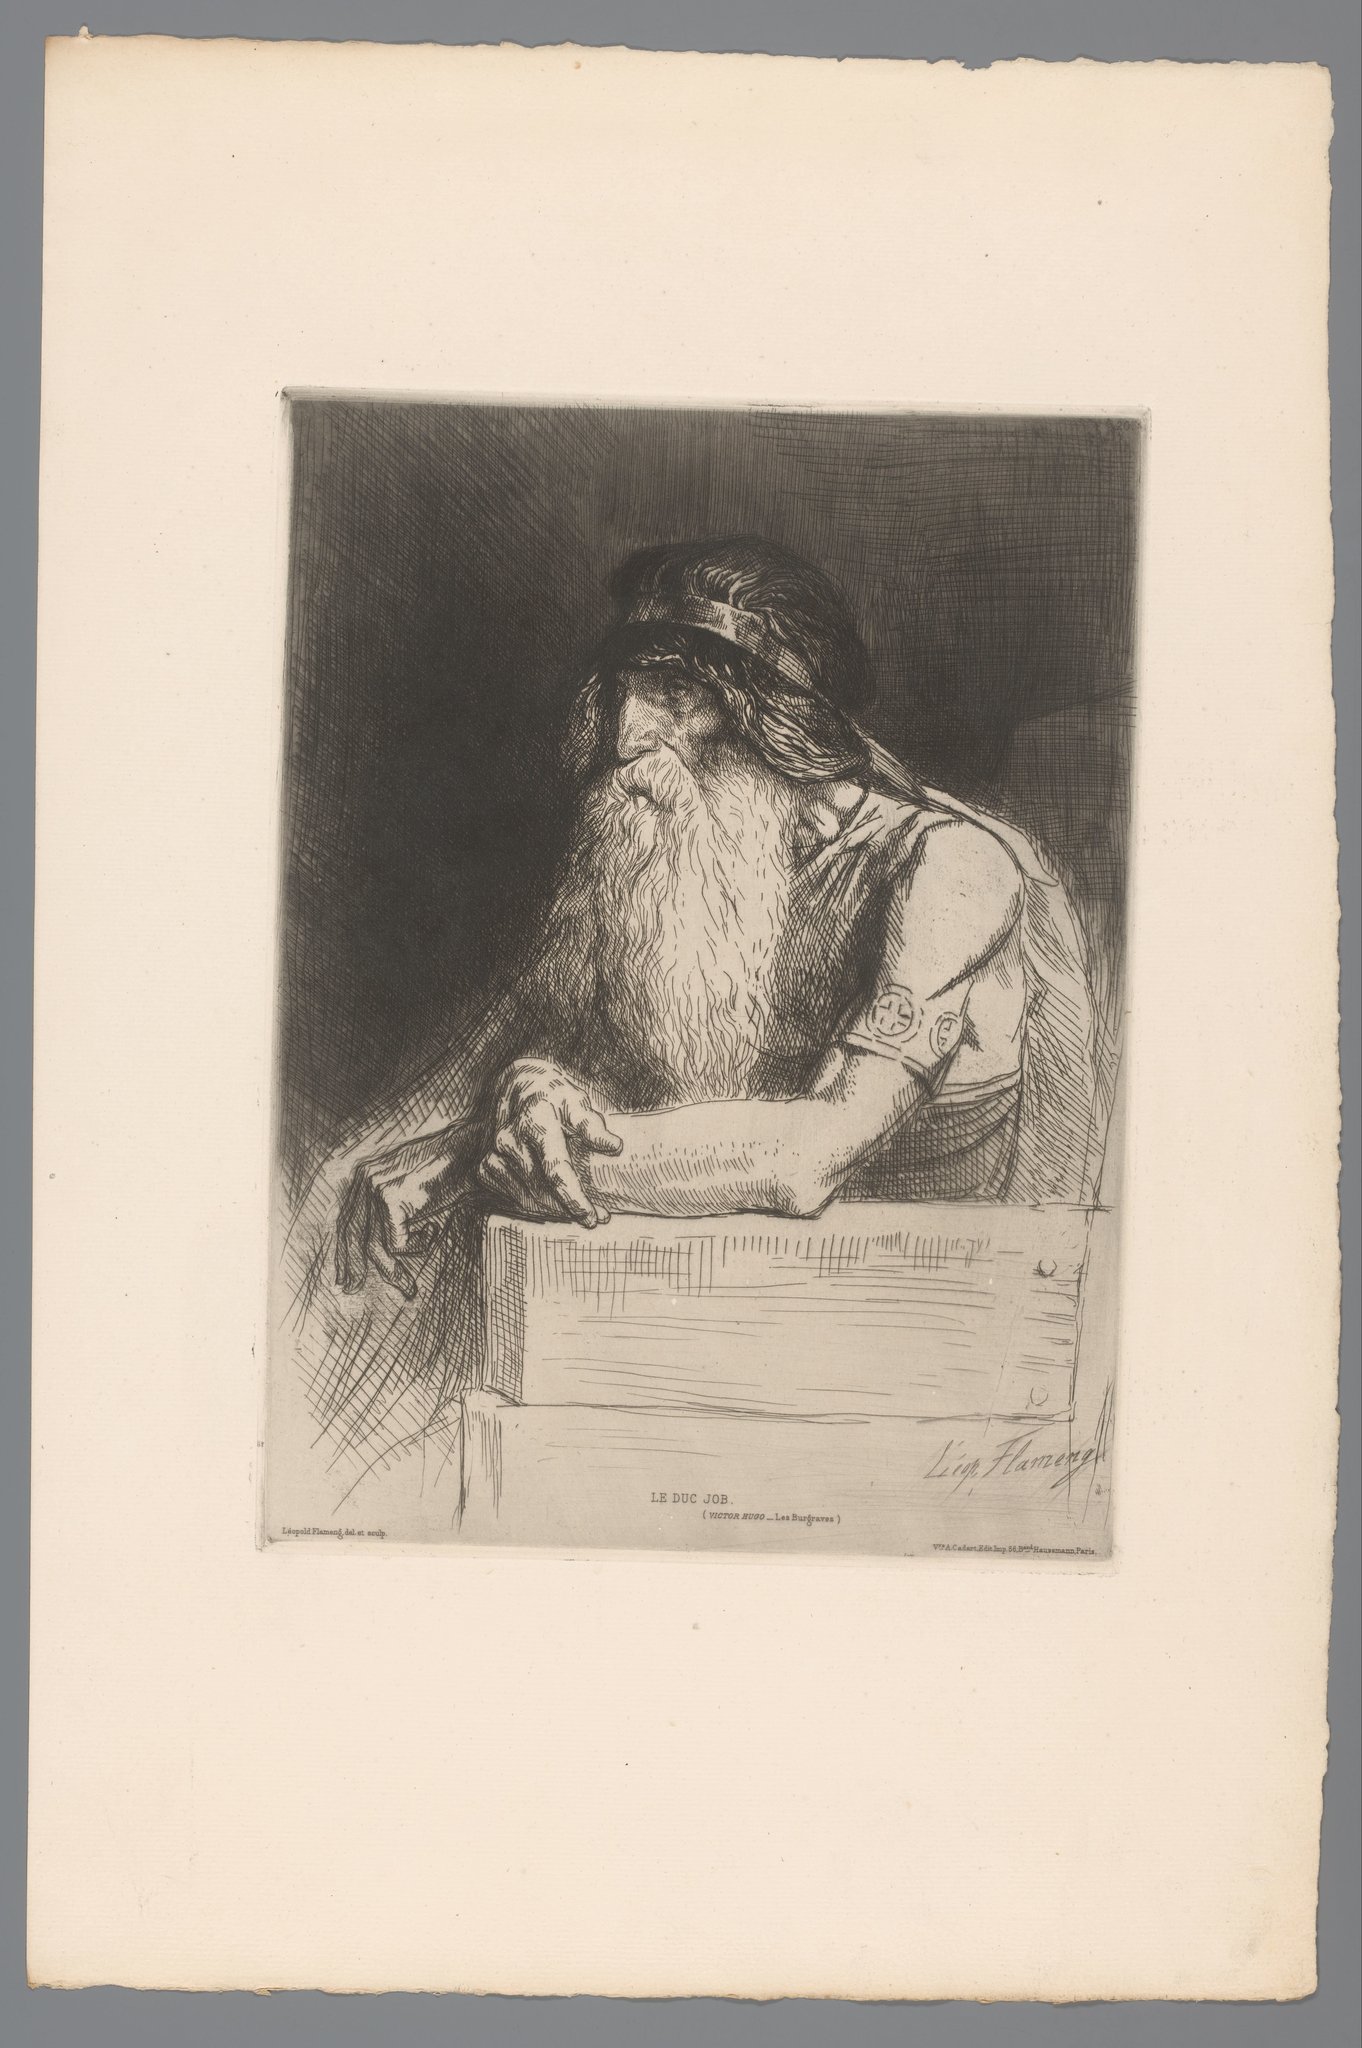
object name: print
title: L'eau-forte en 1877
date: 1877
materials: paper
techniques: drypoint, etching, intaglio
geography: paris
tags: old man, ranks ~ rulers, sovereigns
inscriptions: collector's mark: Lugt 2760, collector's mark: ‘AFE v S’, collector's mark: Lugt 2228